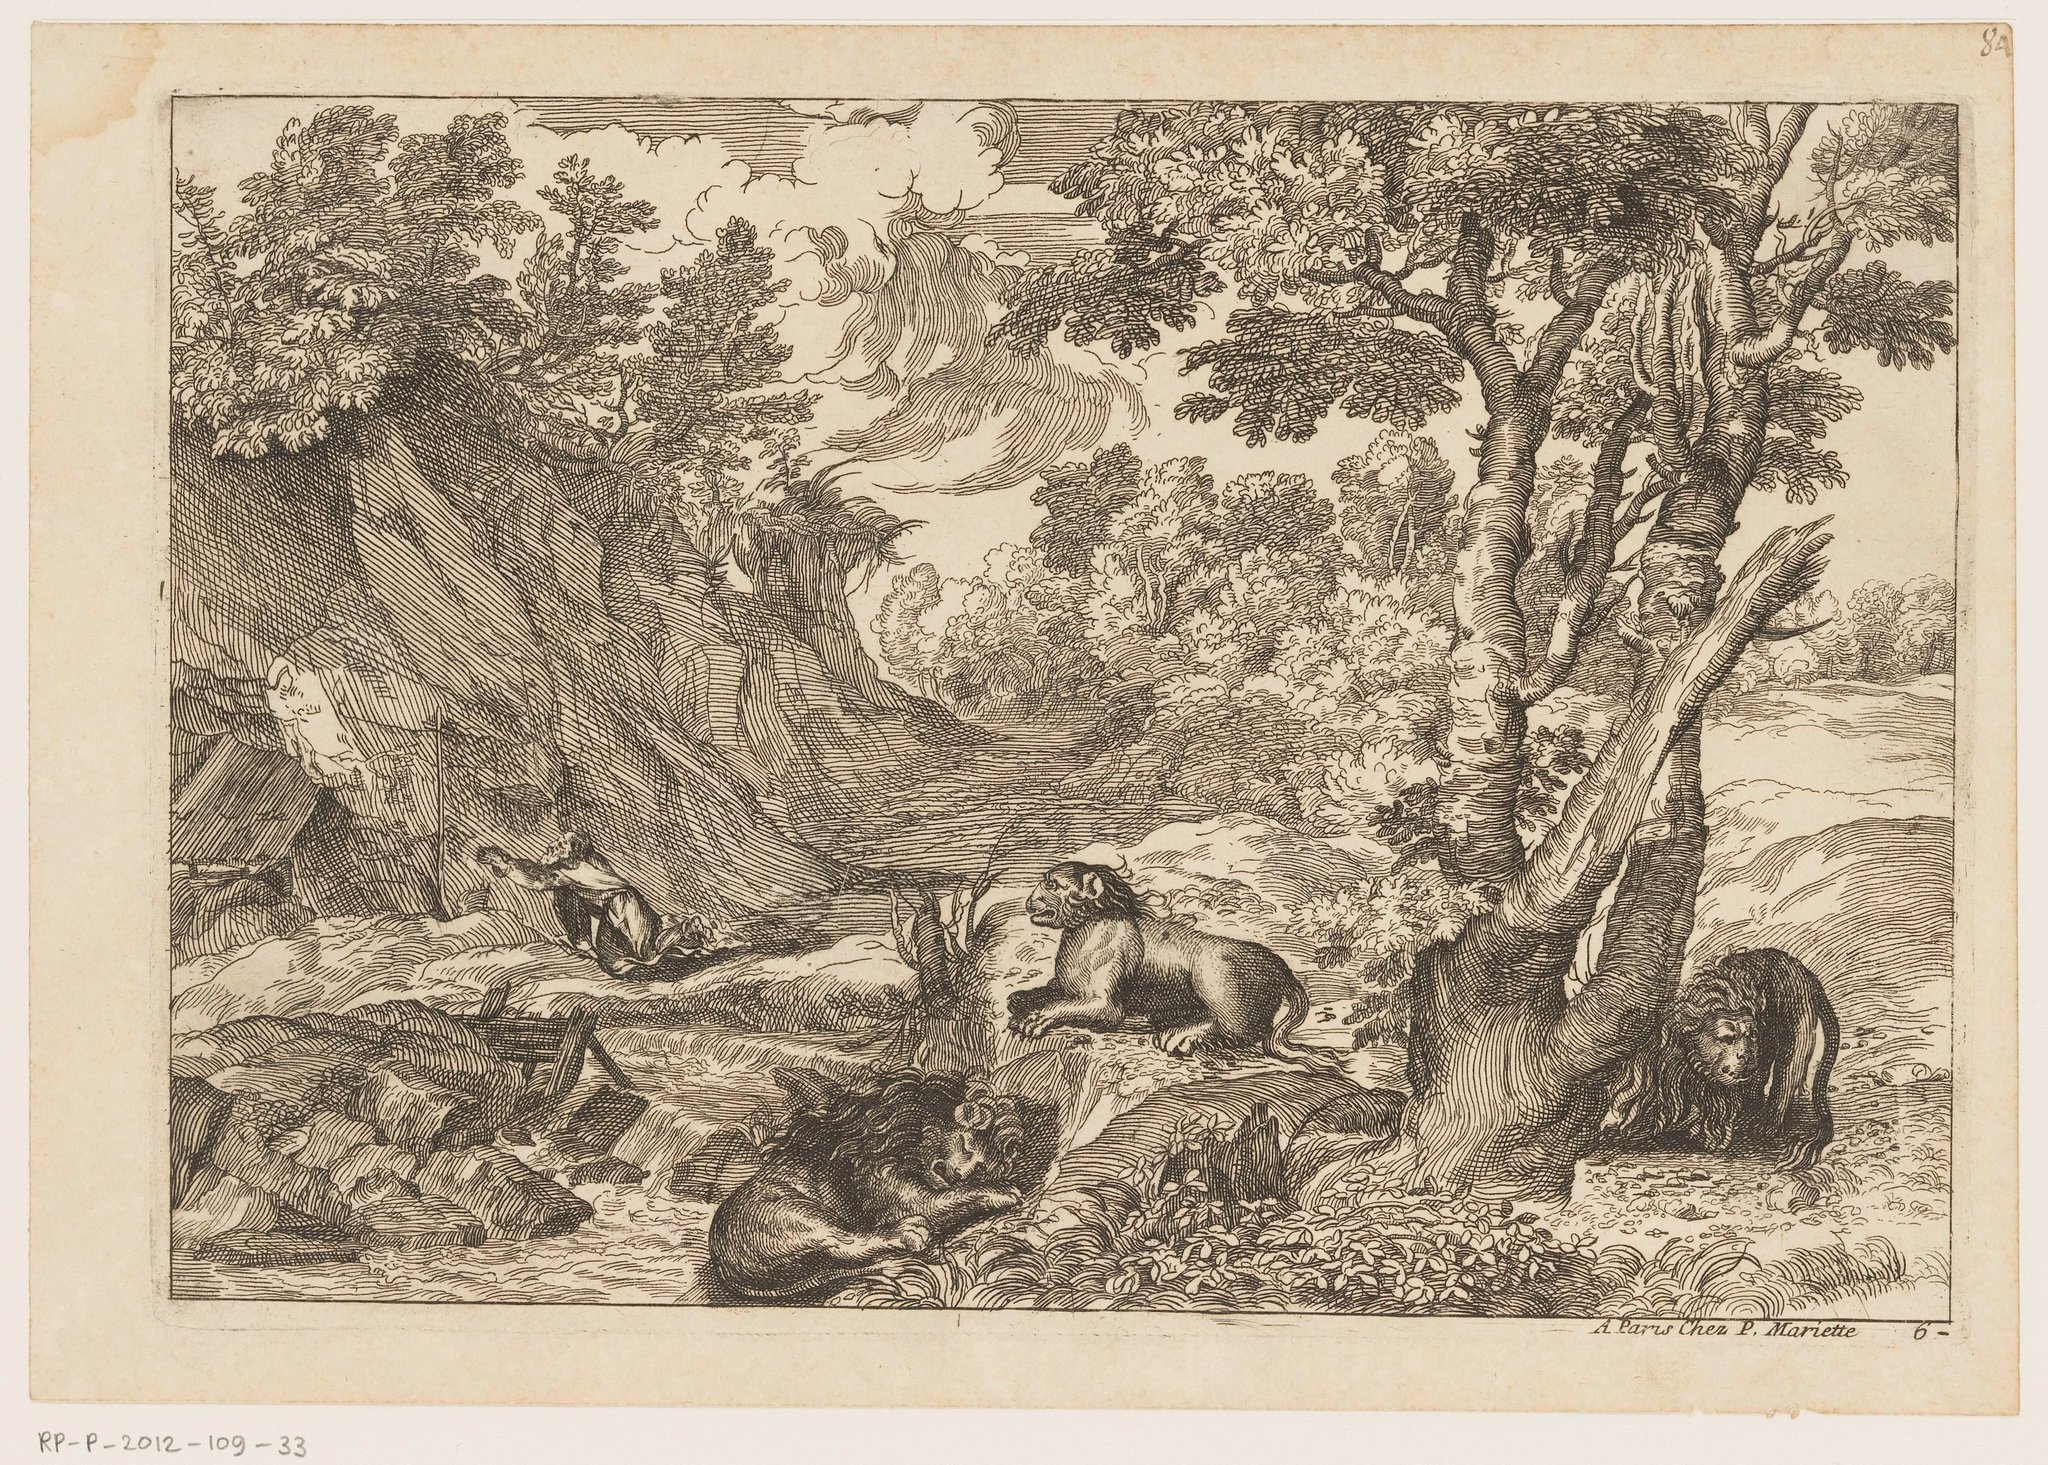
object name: print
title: Landschap met de boetvaardige Hiëronymus en drie rustende leeuwen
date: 1663-1726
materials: paper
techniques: etching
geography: paris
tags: st. jerome as penitent in the desert, half naked, kneeling before a crucifix and holding a stone in his hand to beat his breast; a skull (and other 'vanitas' symbols), sometimes a scorpion and a snake beside him, beasts of prey, predatory animals: lion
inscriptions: collector's mark: Lugt 3474, collector's mark: Lugt 2228, collector's mark: Lugt 3473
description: Maakt deel uit van vierentwintigdelige serie met landschappen naar Titiaan en Campagnola.